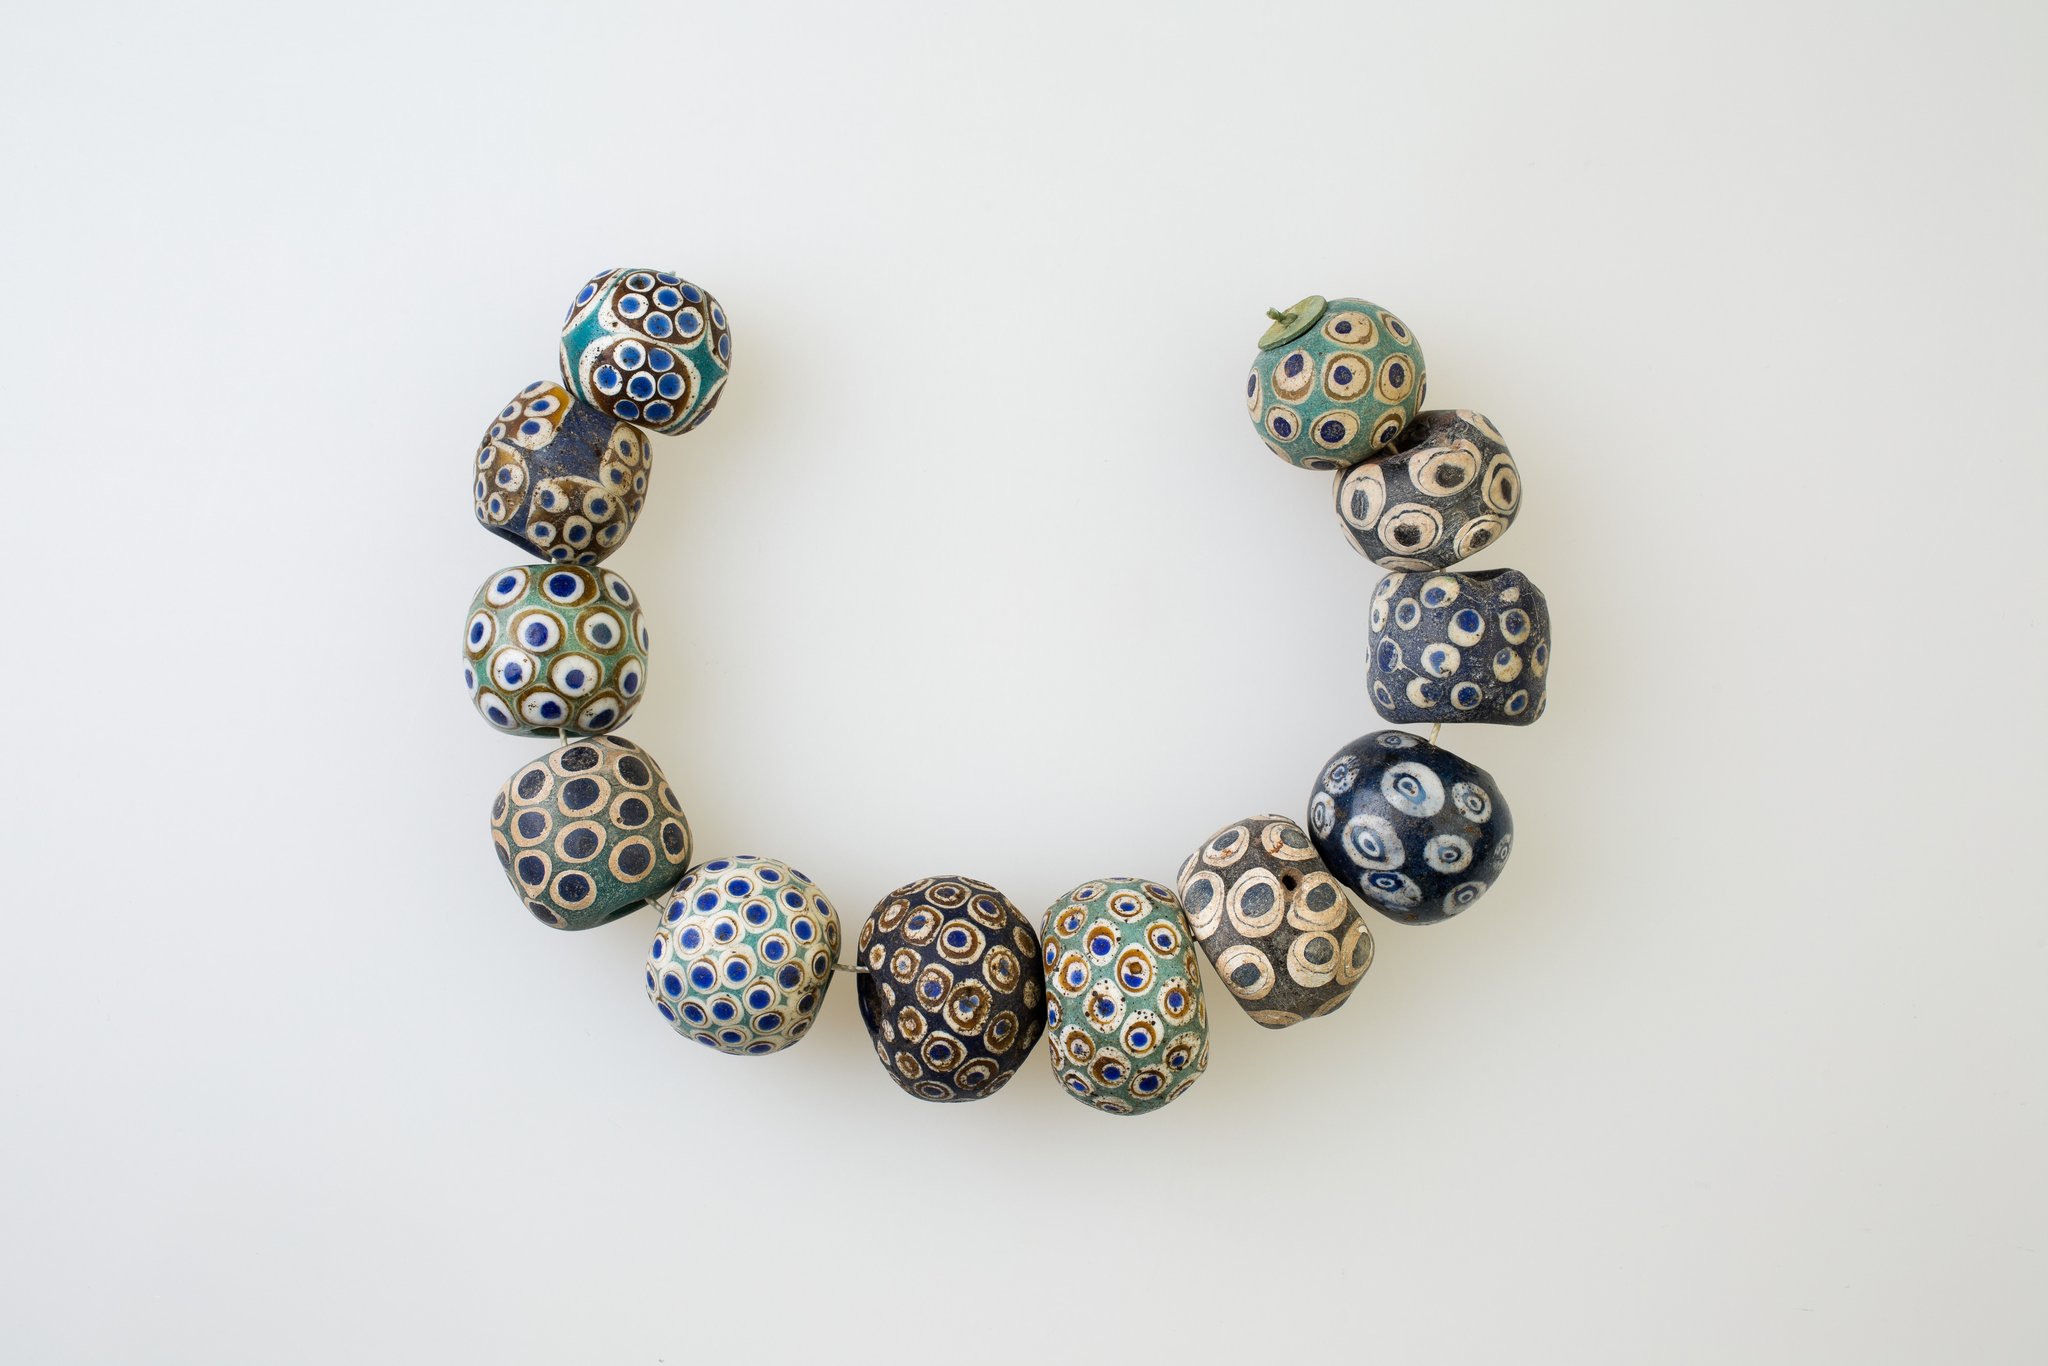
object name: necklace, bead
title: String of 12 Eye Beads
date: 600-201 BCE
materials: glass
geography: egypt